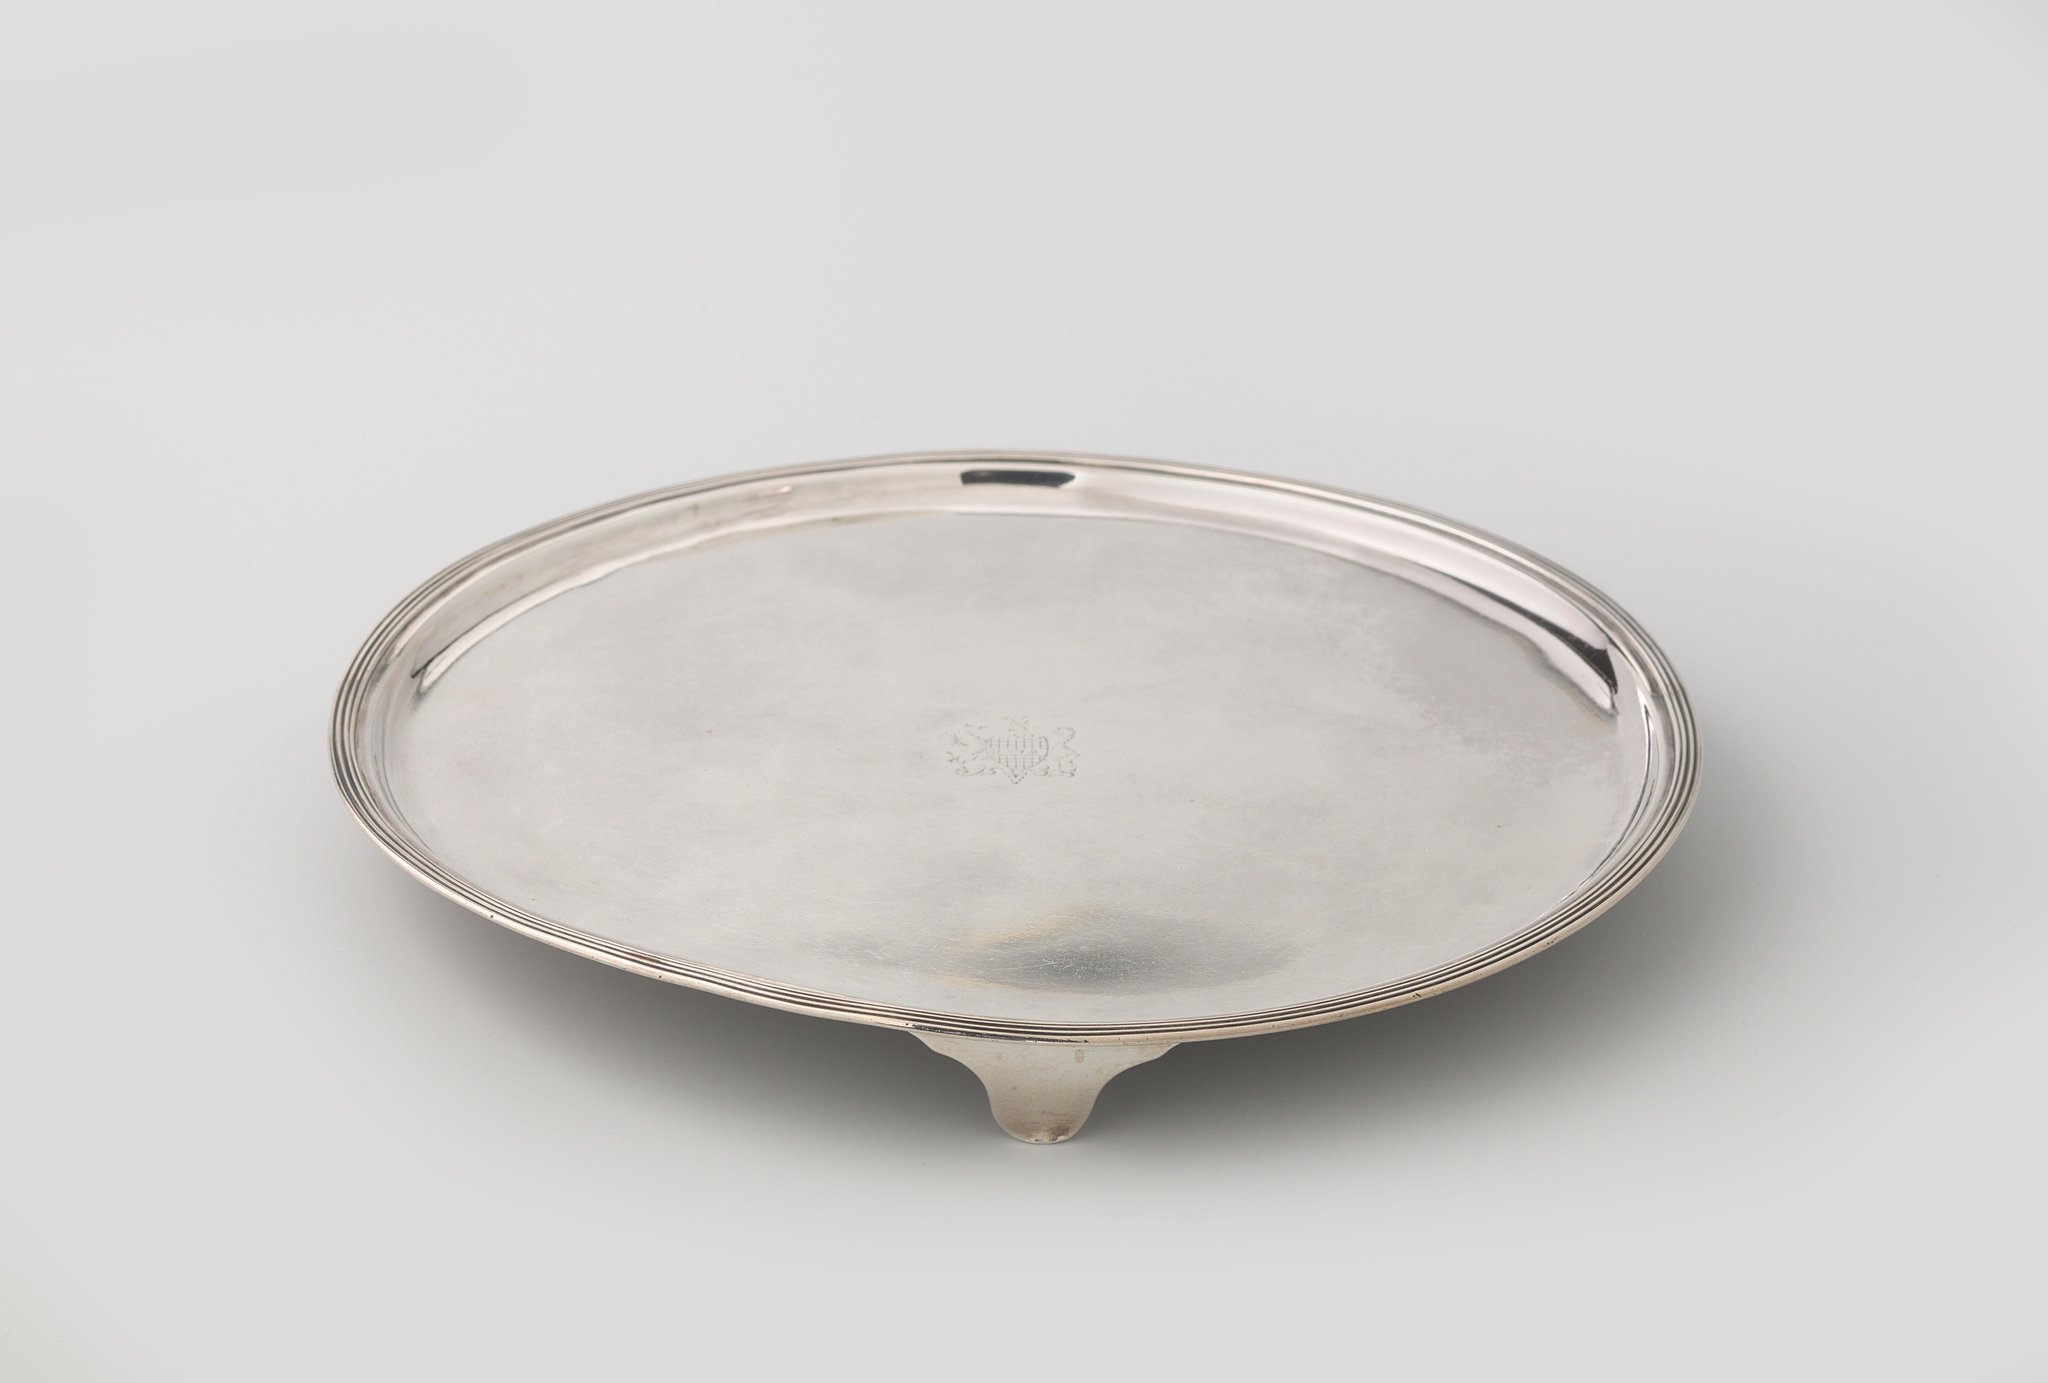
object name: salver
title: Blad met het familiewapen Clifford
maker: diederik willem rethmeyer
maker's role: silversmith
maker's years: 1756-1821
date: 1805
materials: silver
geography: amsterdam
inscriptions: alloy mark, town mark, maker's mark, date letter: ‘W’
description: Het ronde blad rust op drie zich naar beneden toe verjongende, gebogen pootjes en worden aan de bovenzijde omgeven door een filetrand. In het plat van beide is het wapen Clifford met het helmteken en schildhouders gegraveerd.